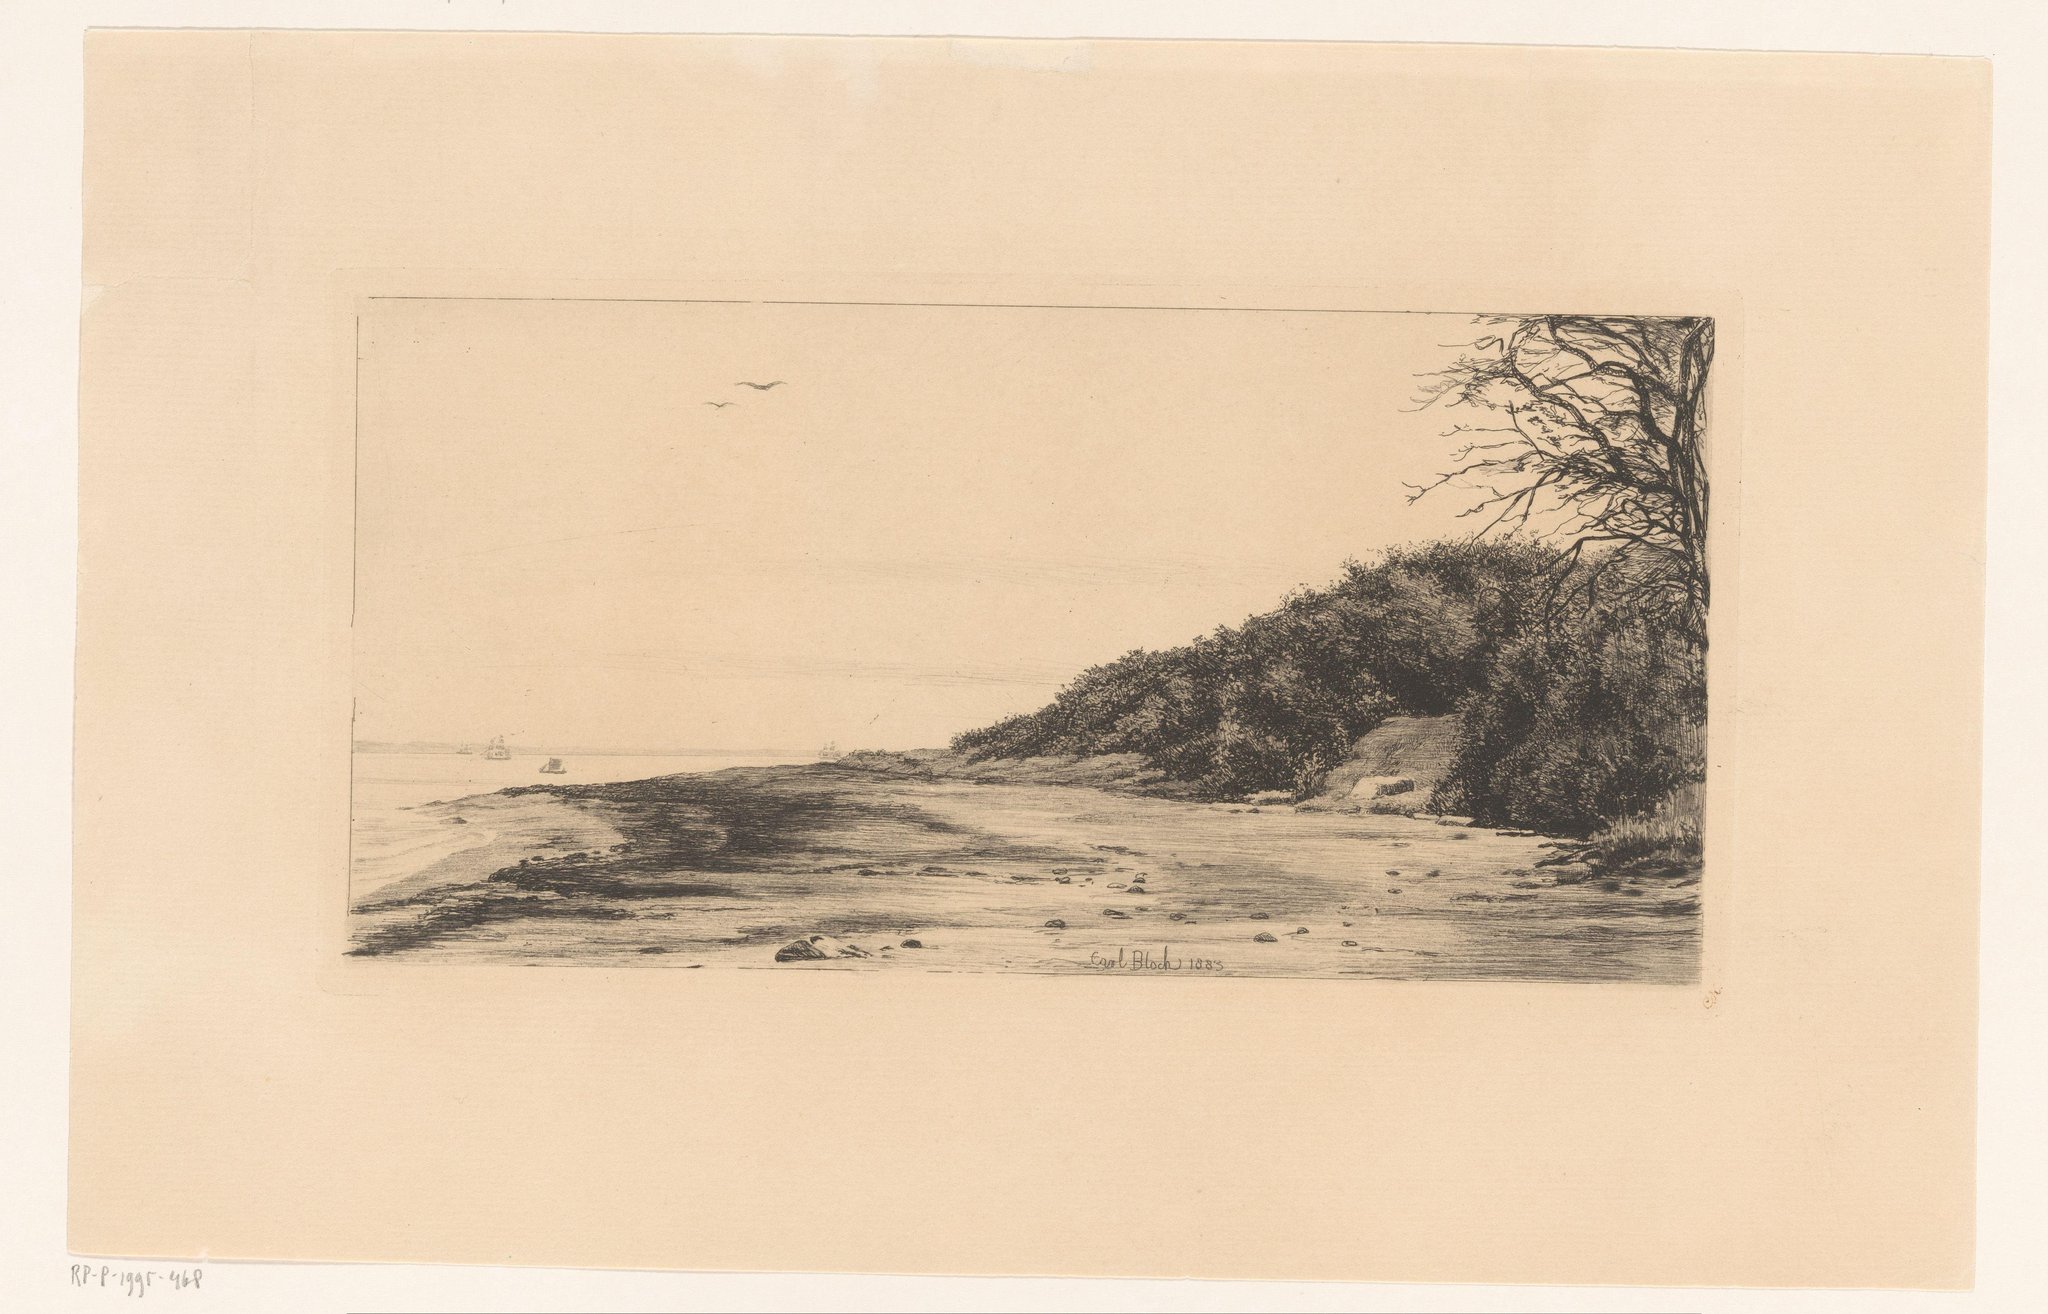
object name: print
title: Bosrand langs water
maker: carl bloch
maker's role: print maker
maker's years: 1834-1890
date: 1883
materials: paper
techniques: drypoint, etching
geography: scandinavia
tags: rocky coast, fringe, edge of the wood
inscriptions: collector's mark: Lugt 2228, signature and date: ‘m.o. gesigneerd en gedateerd Carl Bloch 1883’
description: Strand aan het water, met rechts een bosrand.